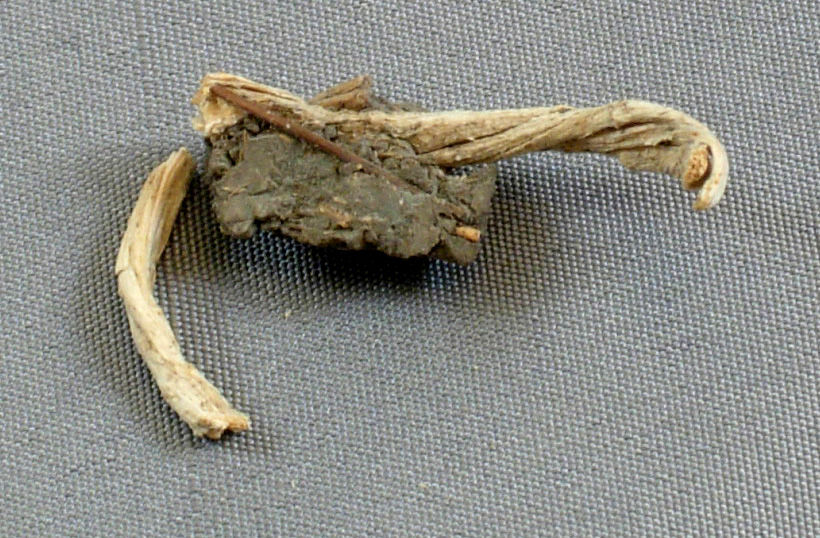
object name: sealing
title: Mud Sealing Attached to a Fiber Tie from Tutankhamun's Embalming Cache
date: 1336-1327 BCE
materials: mud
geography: egypt